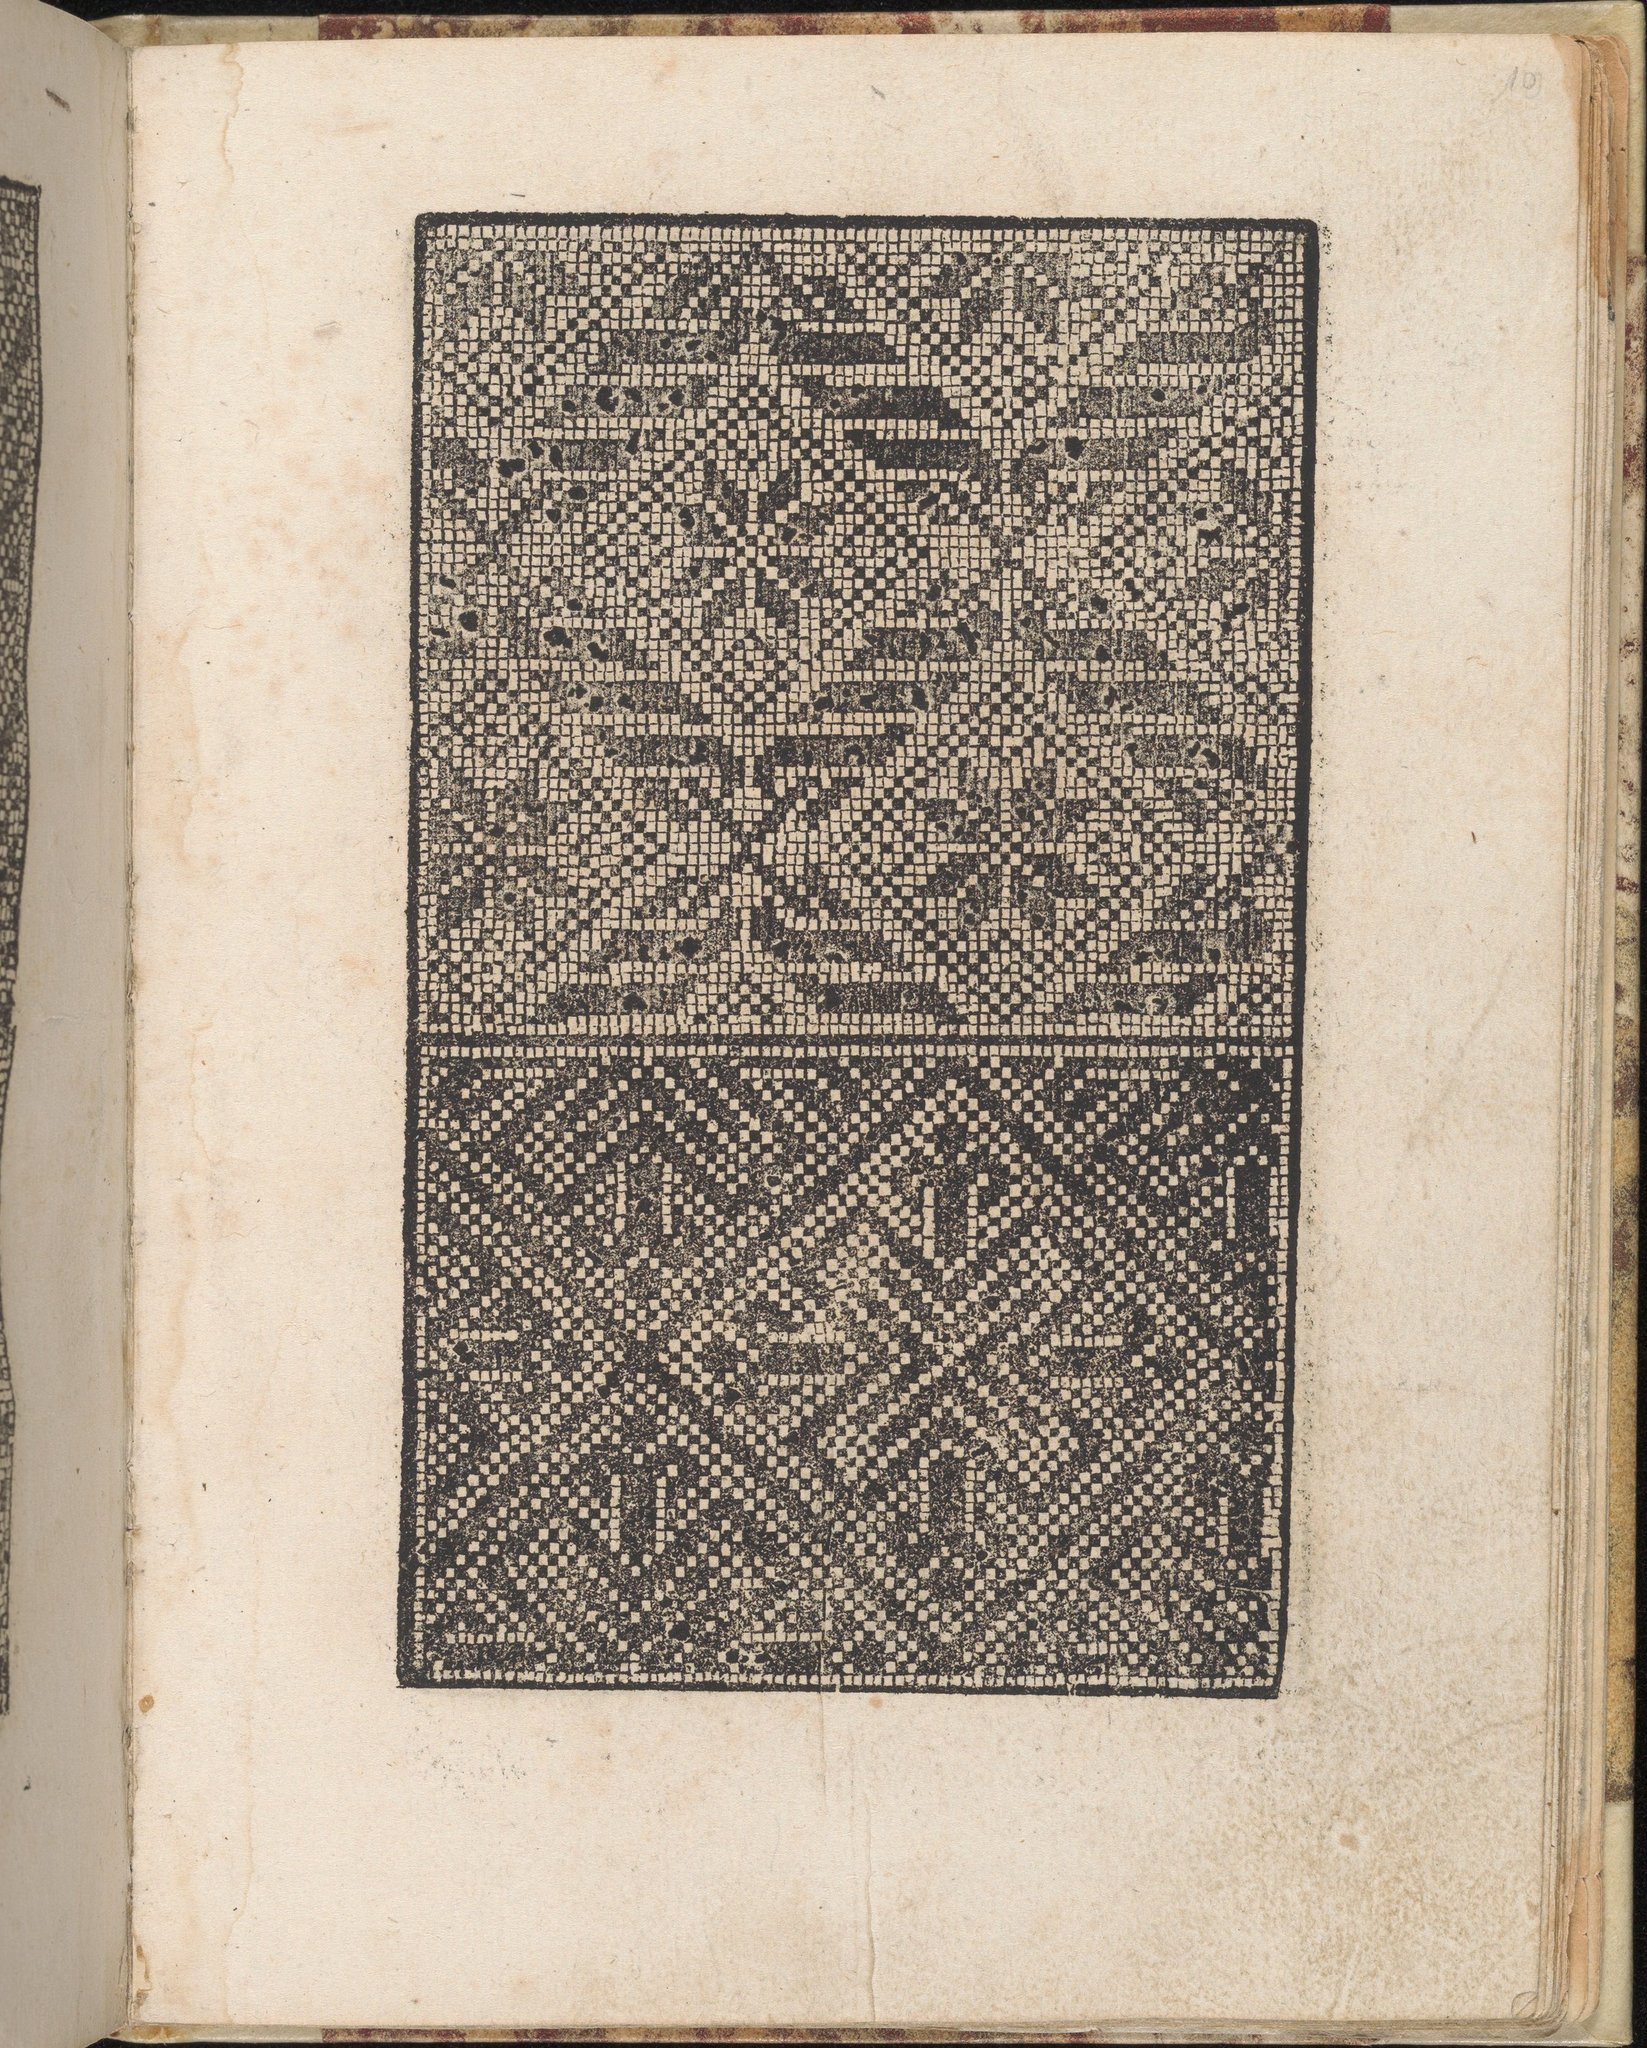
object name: book print ornament architecture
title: Ein new getruckt model Büchli...Page 10, recto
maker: johann schönsperger the younger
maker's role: publisher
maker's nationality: german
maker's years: 1490-1550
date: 1529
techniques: woodcut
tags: ornament